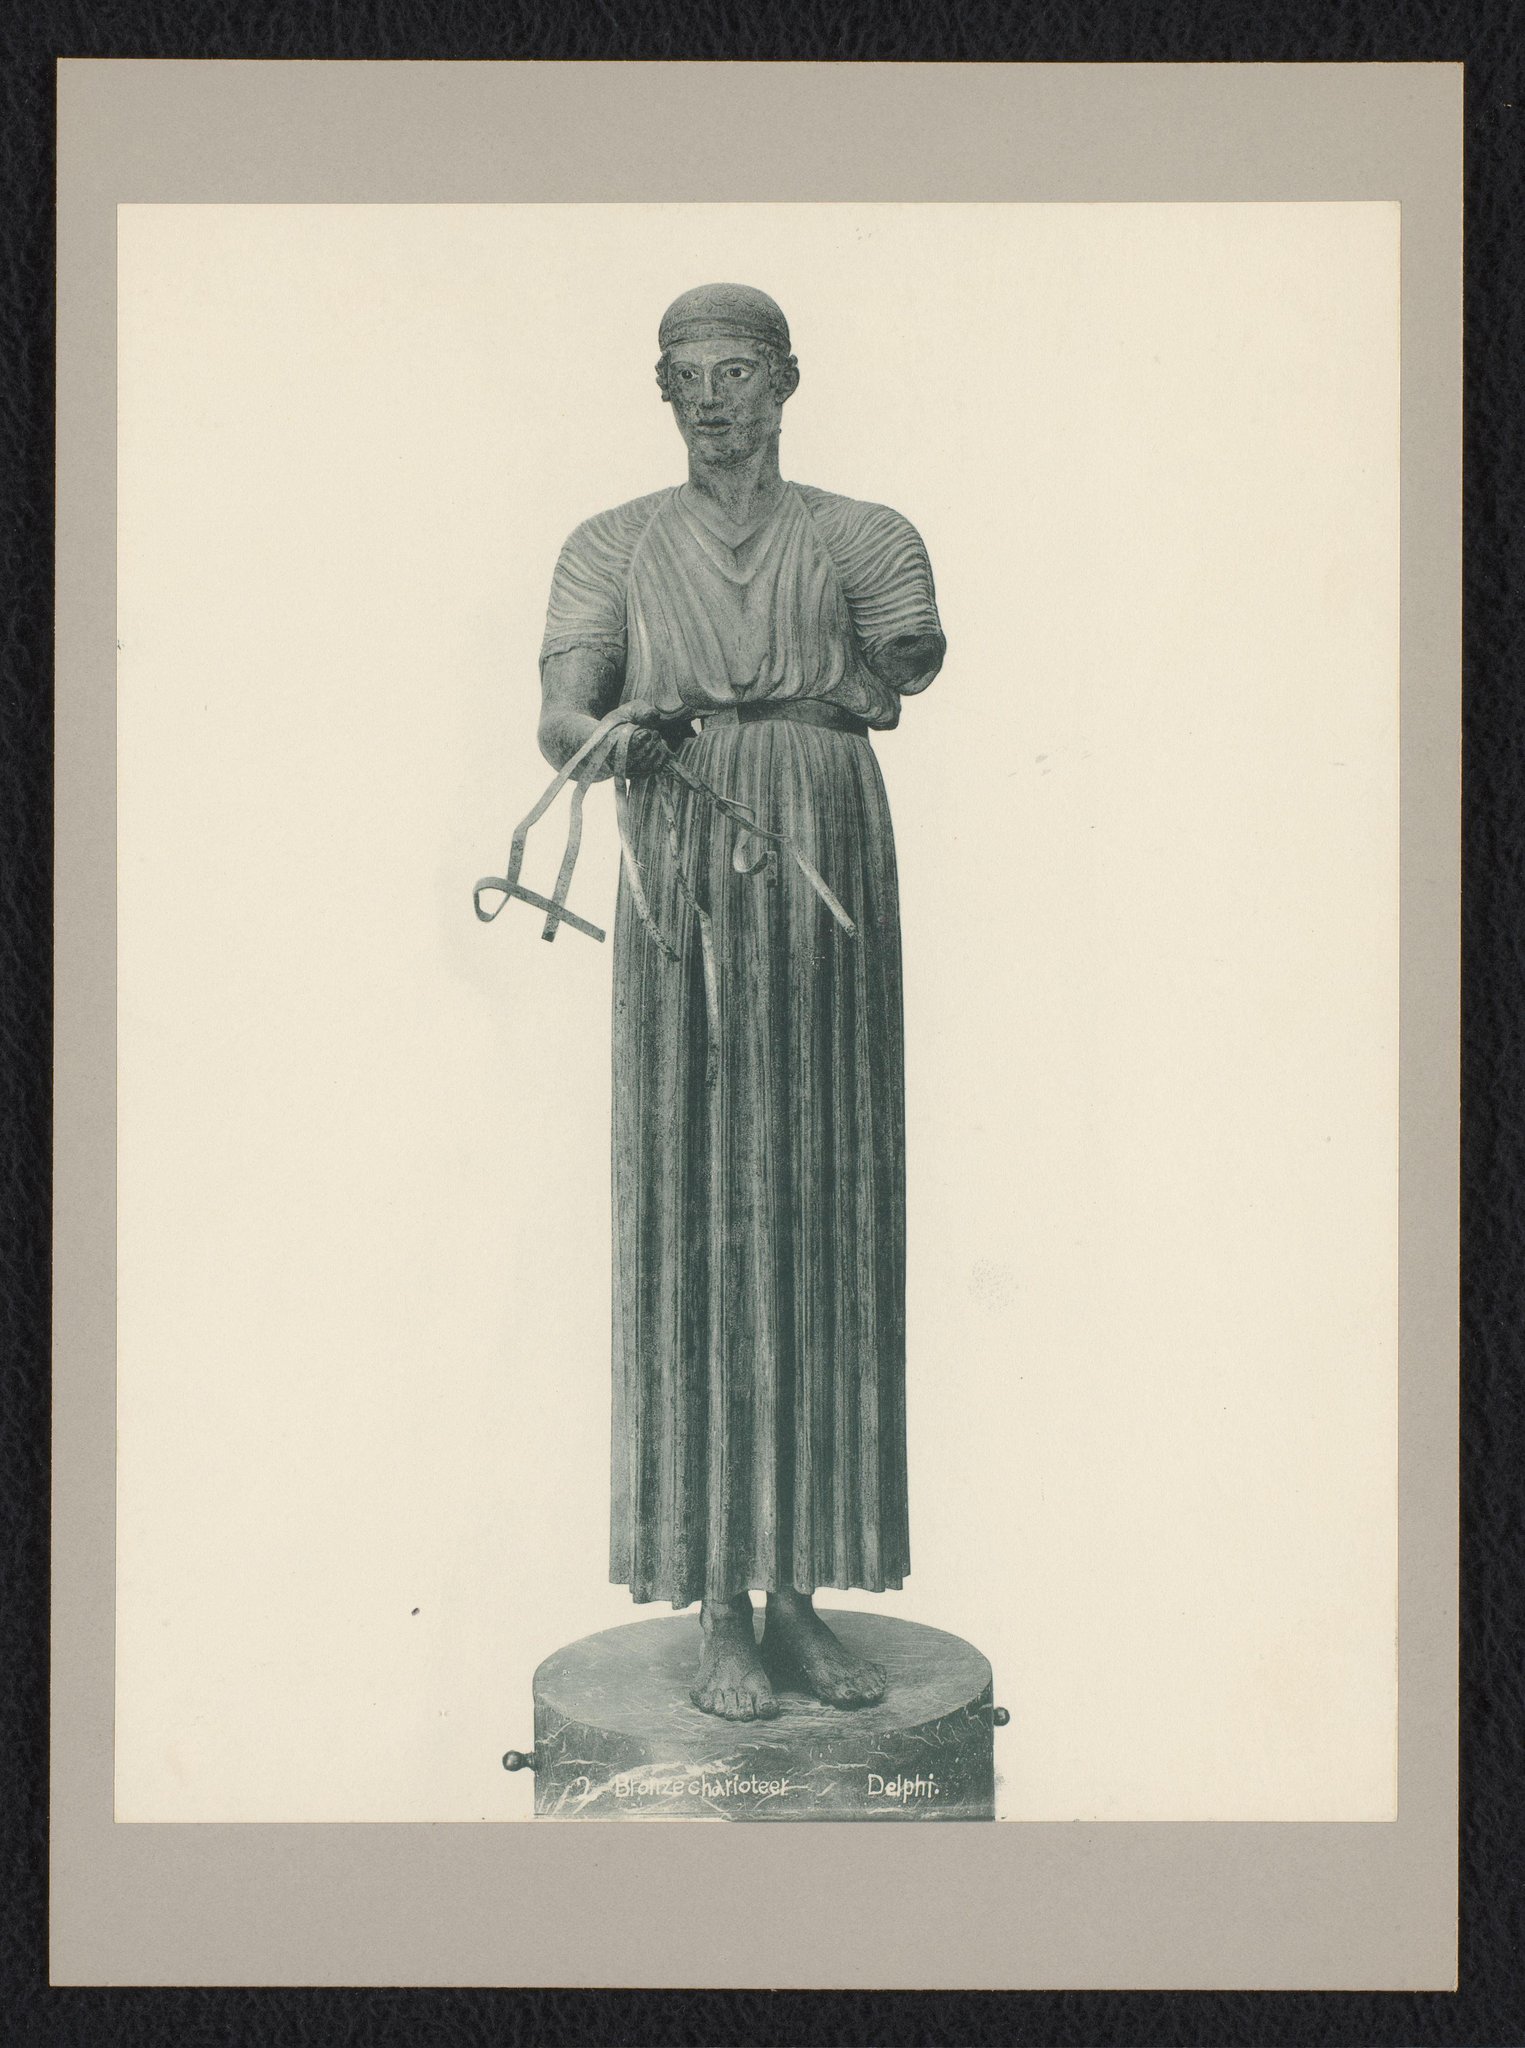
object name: photograph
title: 2 Bronze charioteer Delphi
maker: Anonymous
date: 1895-1915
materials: cardboard, paper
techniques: photograph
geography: delphi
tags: delphi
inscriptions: annotation: ‘19. Wagenmenner’